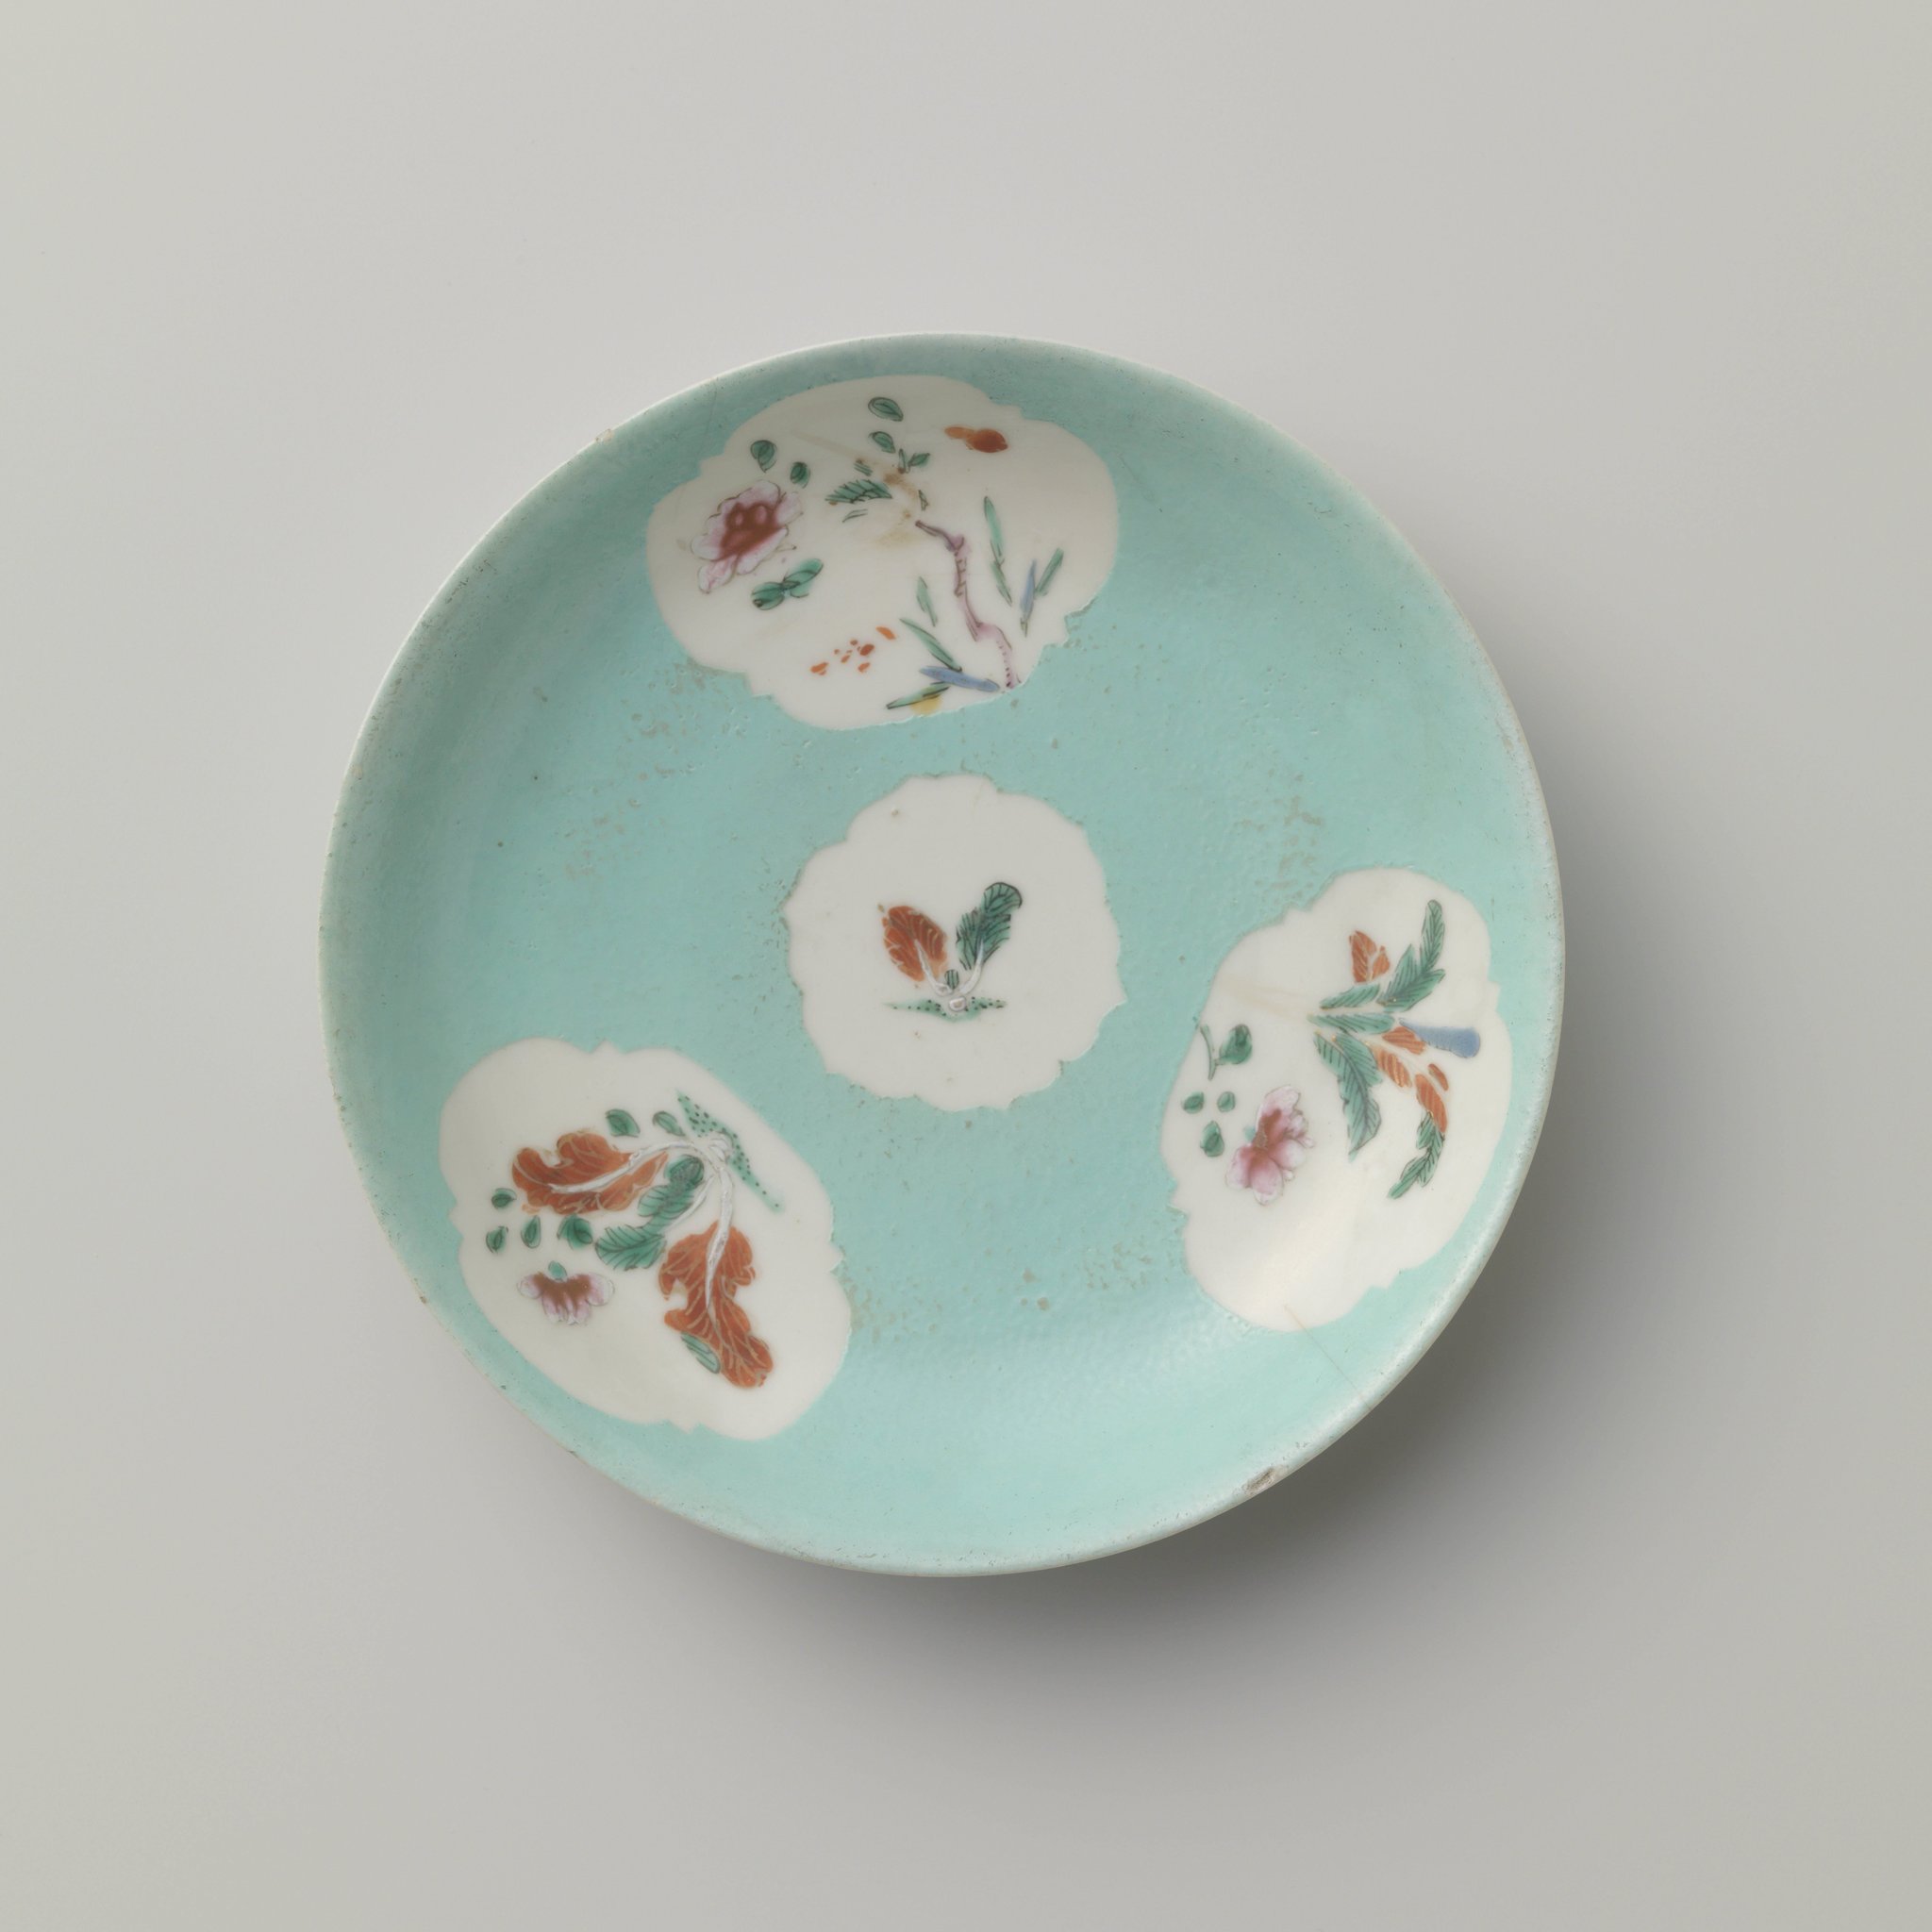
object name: kop en schotel, kop en schotel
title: Saucer with flowering plants in shaped panels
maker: Anonymous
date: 1760-1780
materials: glaze, gold, paint, porcelain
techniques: firing, gilding, turning, vitrification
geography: china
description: Schotel van porselein, bedekt met een turquoise glazuur en berschilderd in blauw, rood, roze, groen, zwart en goud. De schotel is aan de voorzijde bedekt met een turquoise glazuur met hierin uitgespaard in het centrum een geschulpt medaillon met plant, daaromheen drie uitgespaarde cartouches met bloeiende planten en een vogel op een tak. Twee barsten en een chip in de schotel. Famille rose.